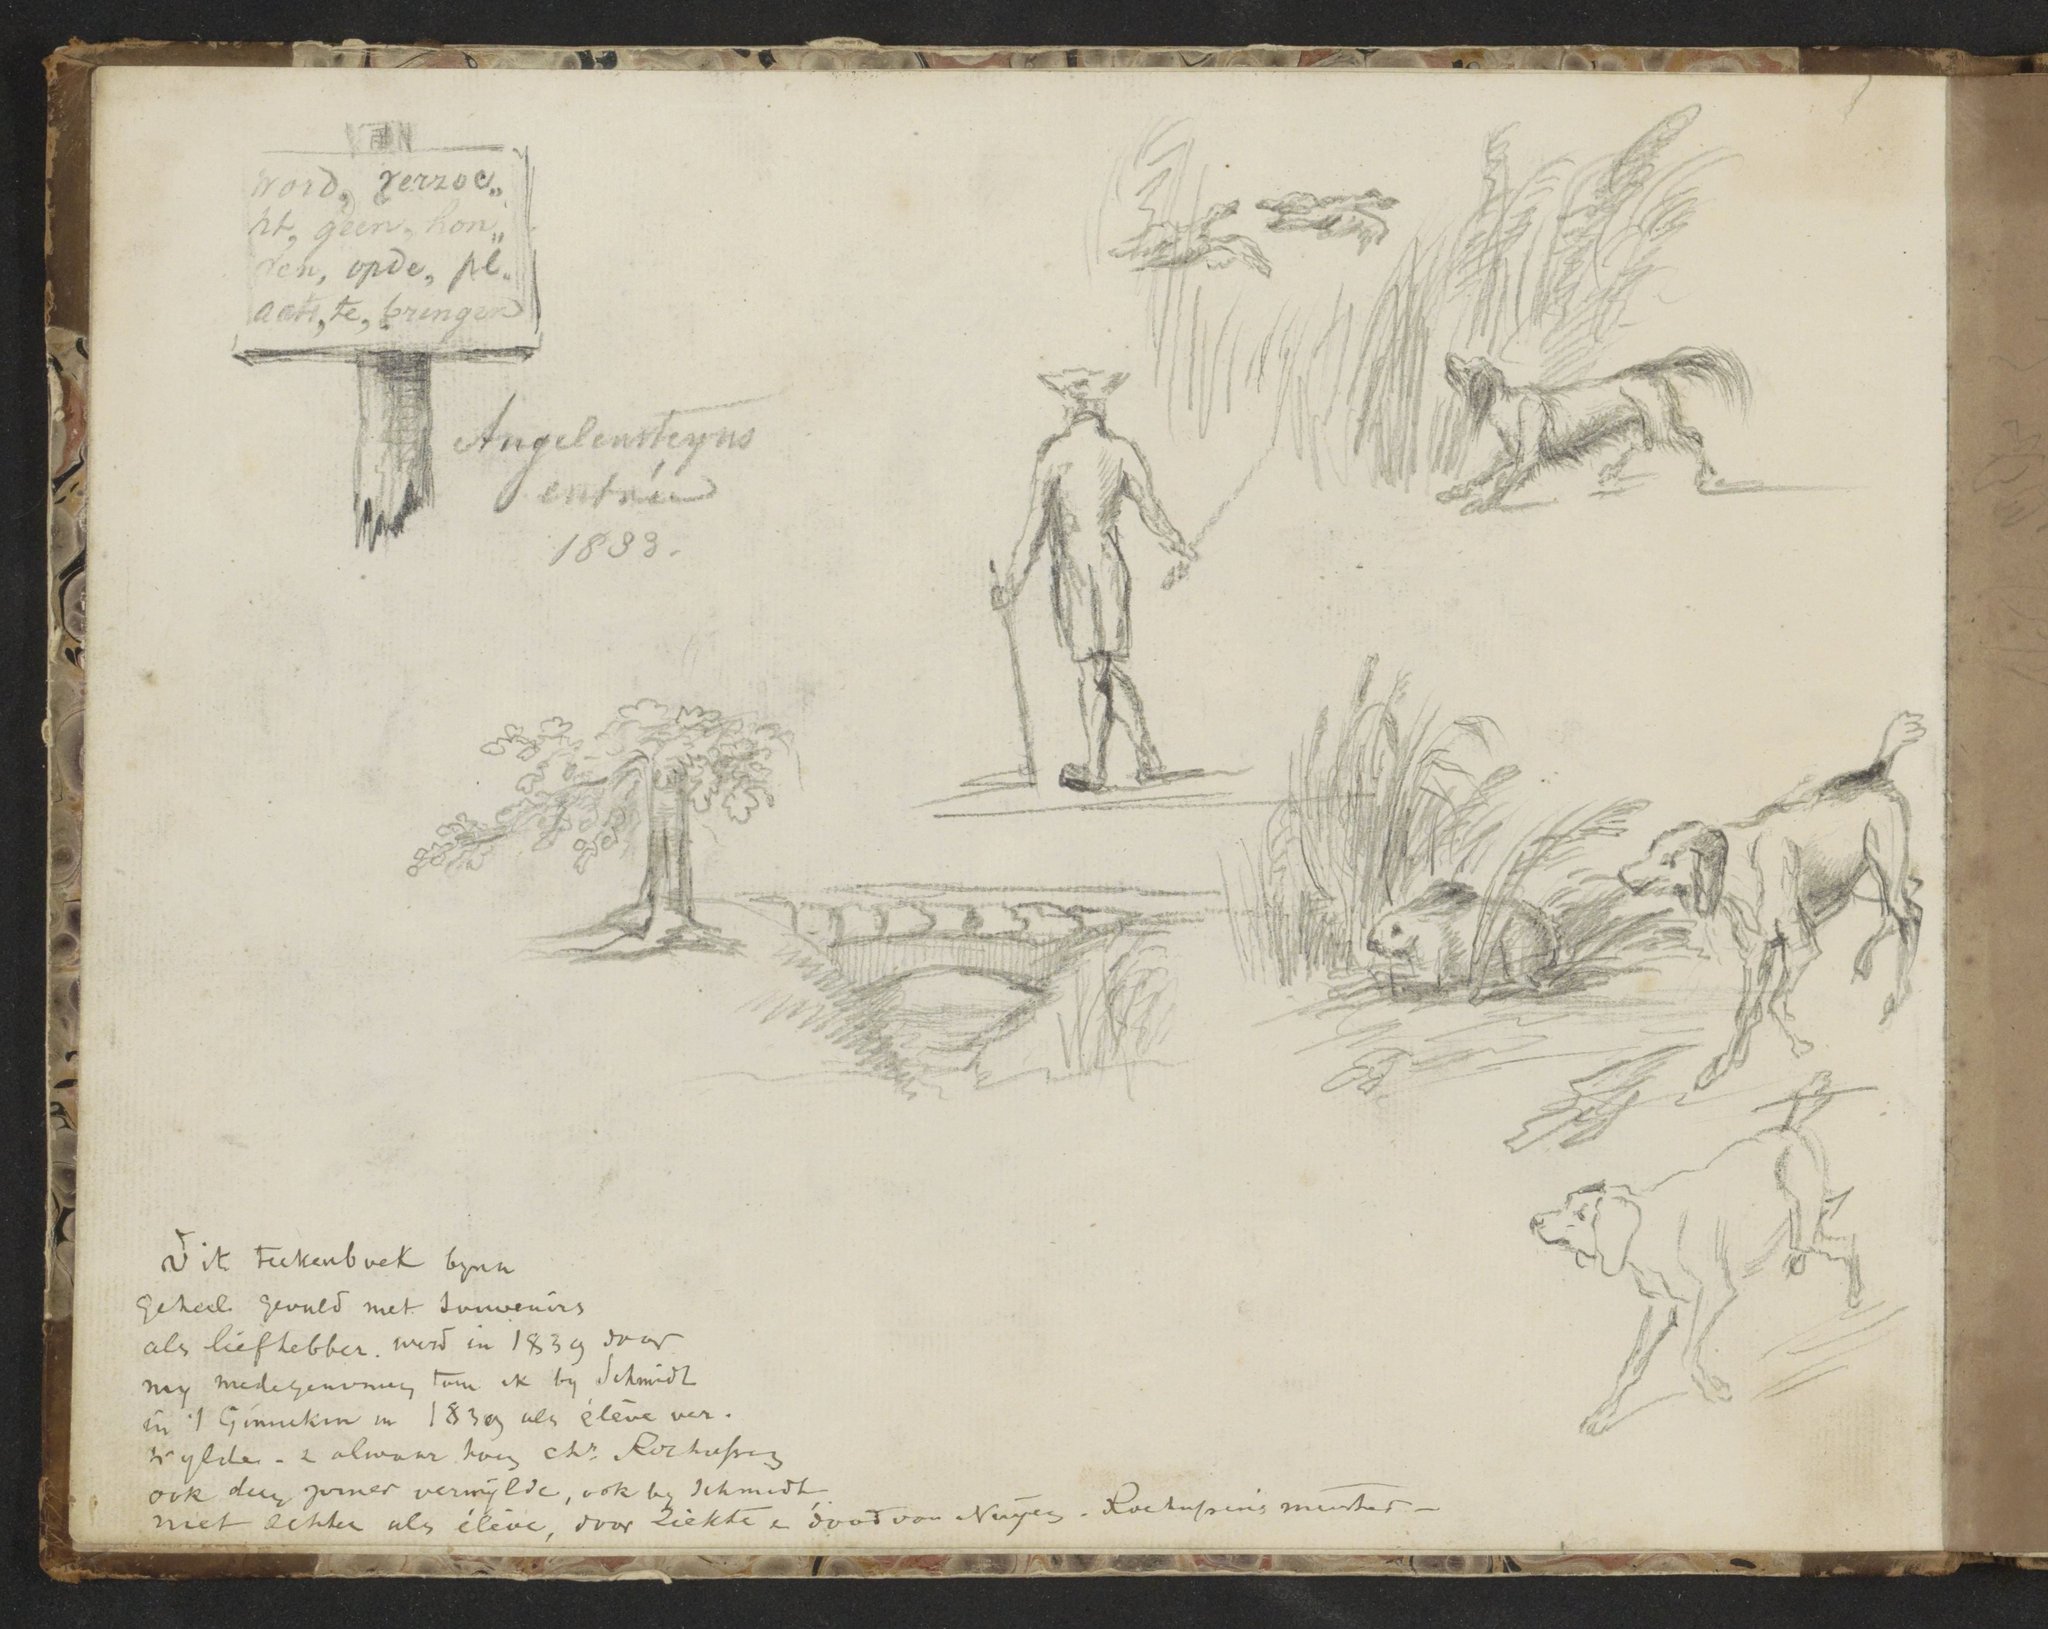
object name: sketchbook leaf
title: Wandelaar, honden, vogels en een brug in Park Angerenstein te Arnhem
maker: johannes tavenraat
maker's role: draughtsman, painter, print maker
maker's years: 1809-1881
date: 1833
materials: paper, pencil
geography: arnhem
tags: trees, birds, walking, bridge, rodents: rabbit, dog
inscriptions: date and inscription: ‘Angerensteyns/ entrée/ 1833./ Dit teekenboek bijna/ geheel gevuld met souvenirs/ als liefhebber. werd in 1839 door/ mij medegenomen toen ik bij Schmidt/ in 't Ginneken in 1839 als élève ver-/ wijlde - & alwaar toen Chs Rochussen/ ook den zomer verwijlde, ook bij Schmidt/ niet echter als élève, door ziekte en dood van Niujen, Rochussens meester-’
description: Tevens een studie van het entreebord van het park, een boom en een konijn in het gras. Blad 1 verso uit een schetsboek met 41 bladen.